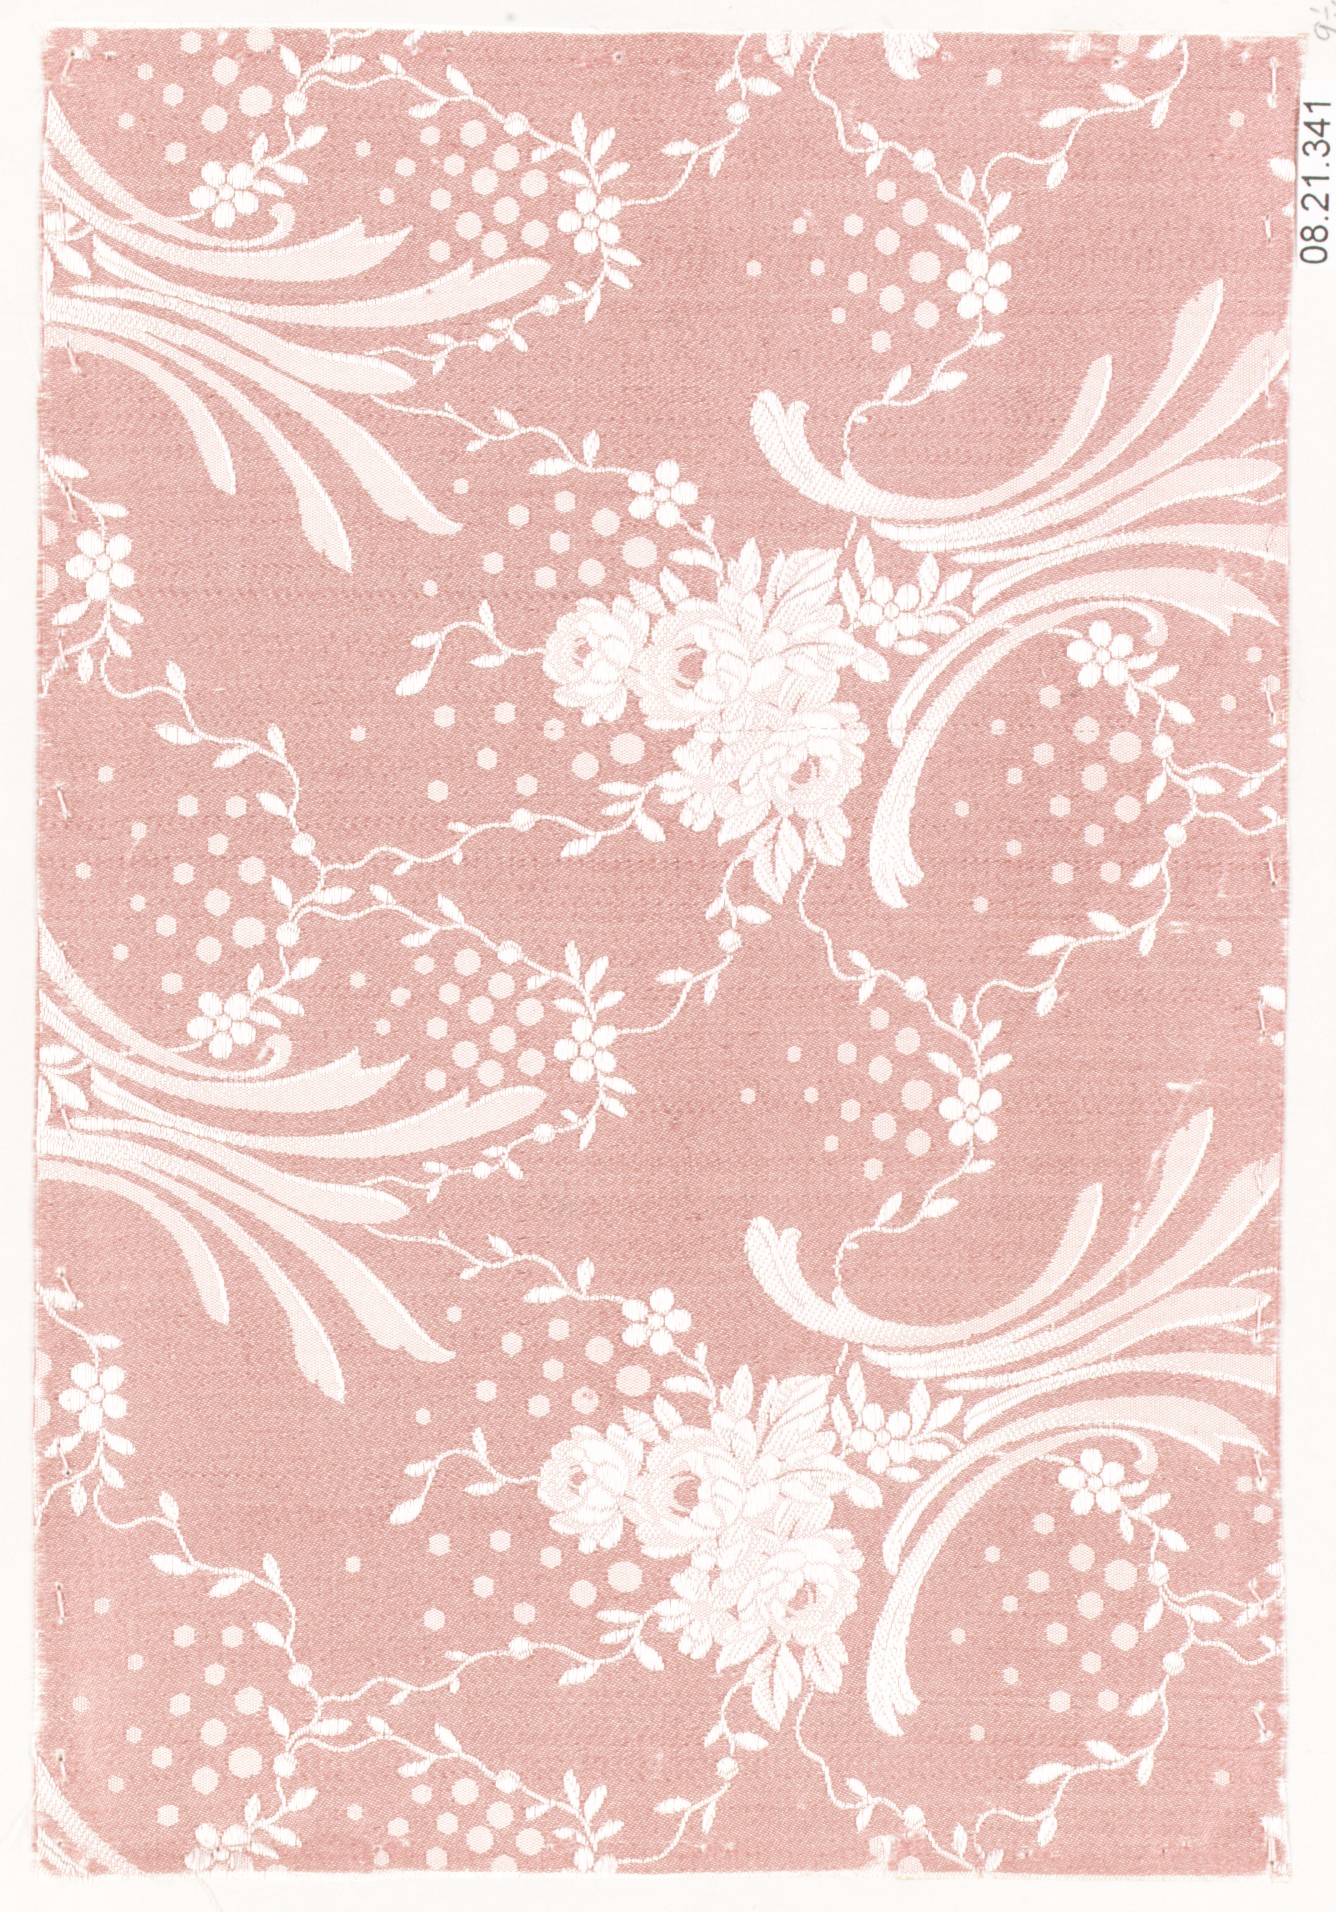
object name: textile sample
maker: Anonymous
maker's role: designer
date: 1900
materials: silk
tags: flowers